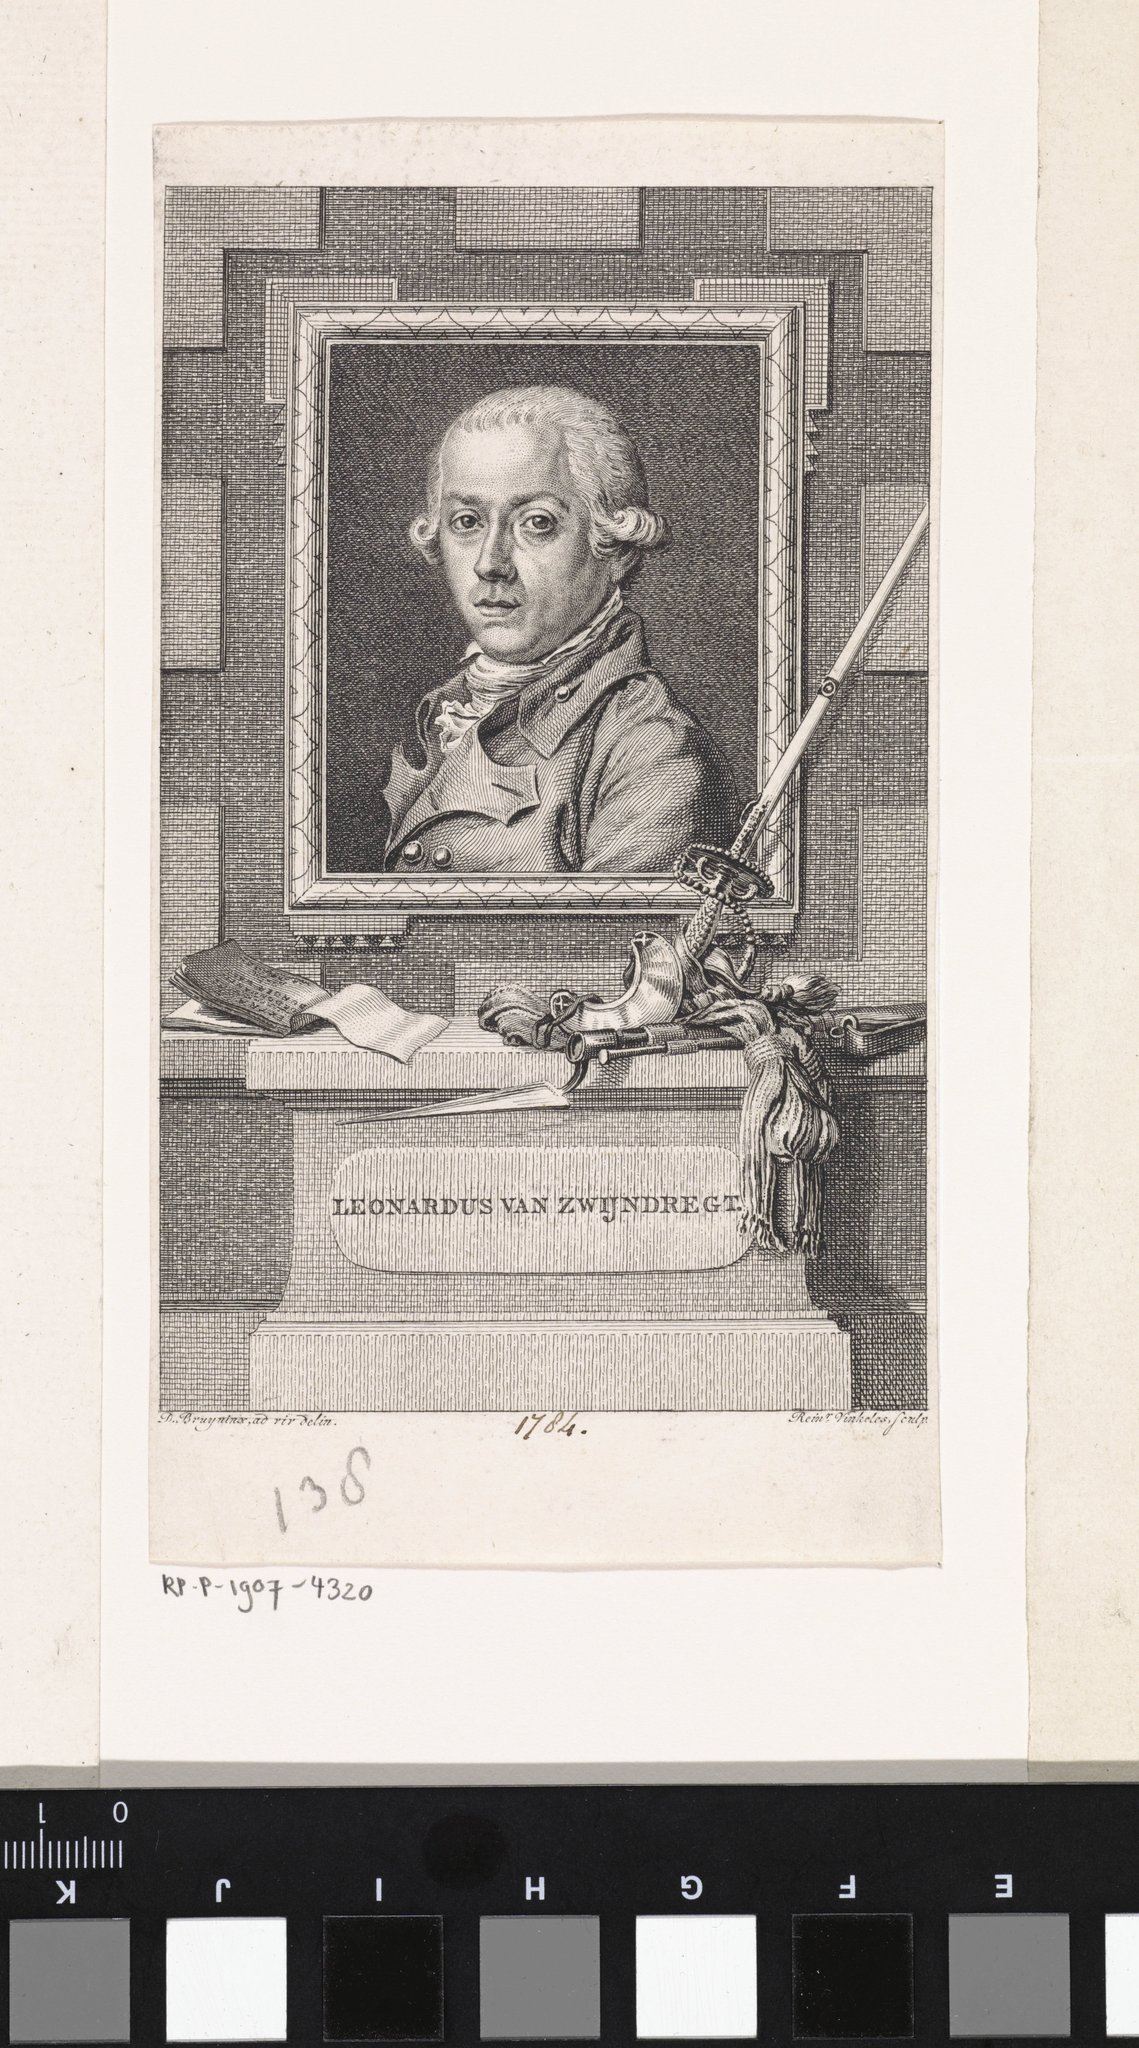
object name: print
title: Portret van Leonardus van Zwijndregt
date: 1792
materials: paper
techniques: engraving, etching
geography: amsterdam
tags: rotterdam, helved weapons, polearms (for striking, hacking, thrusting) (with name), book, hacking and thrusting weapons: rapier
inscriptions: collector's mark: Lugt 2228, inscription: ‘1784’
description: Prent waarschijnlijk uit: Wagenaar, Jan. Vaderlandsche Historie, Vervattende De Geschiedenissen Vereenigde Nederlanden (...). Amsterdam: Johannes Allart, 1792, dl. 8.